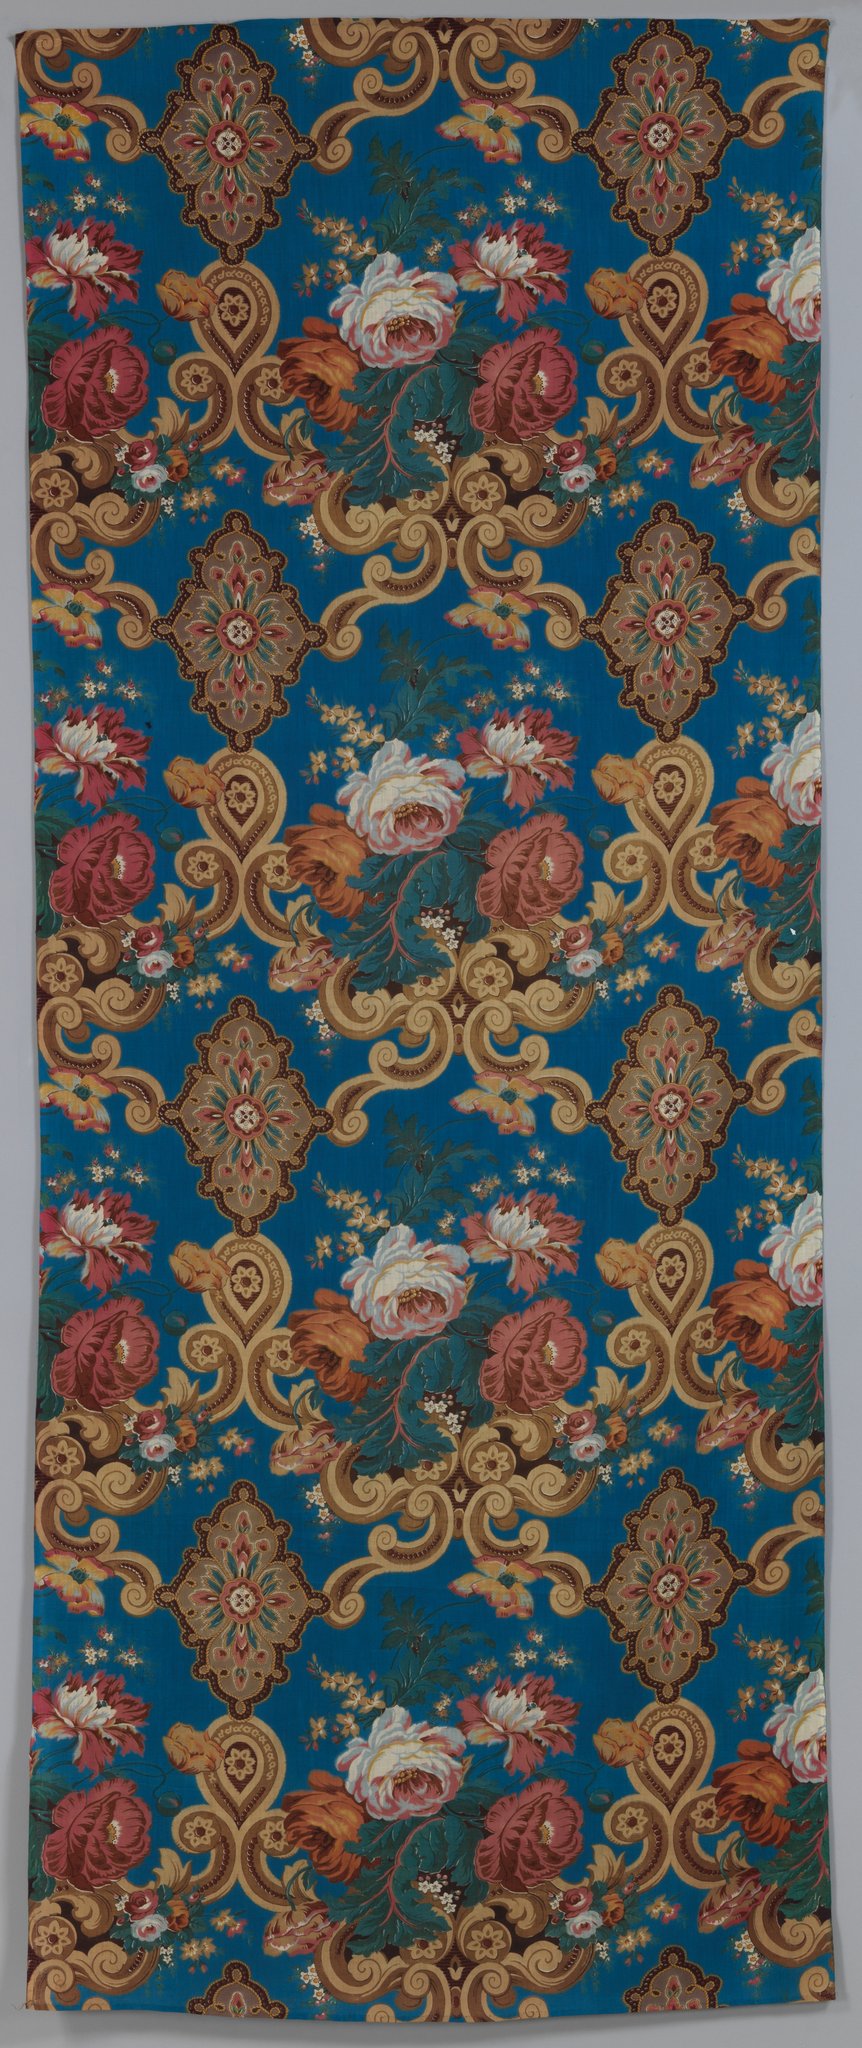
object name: piece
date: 1834-1866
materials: cotton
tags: roses,leaves